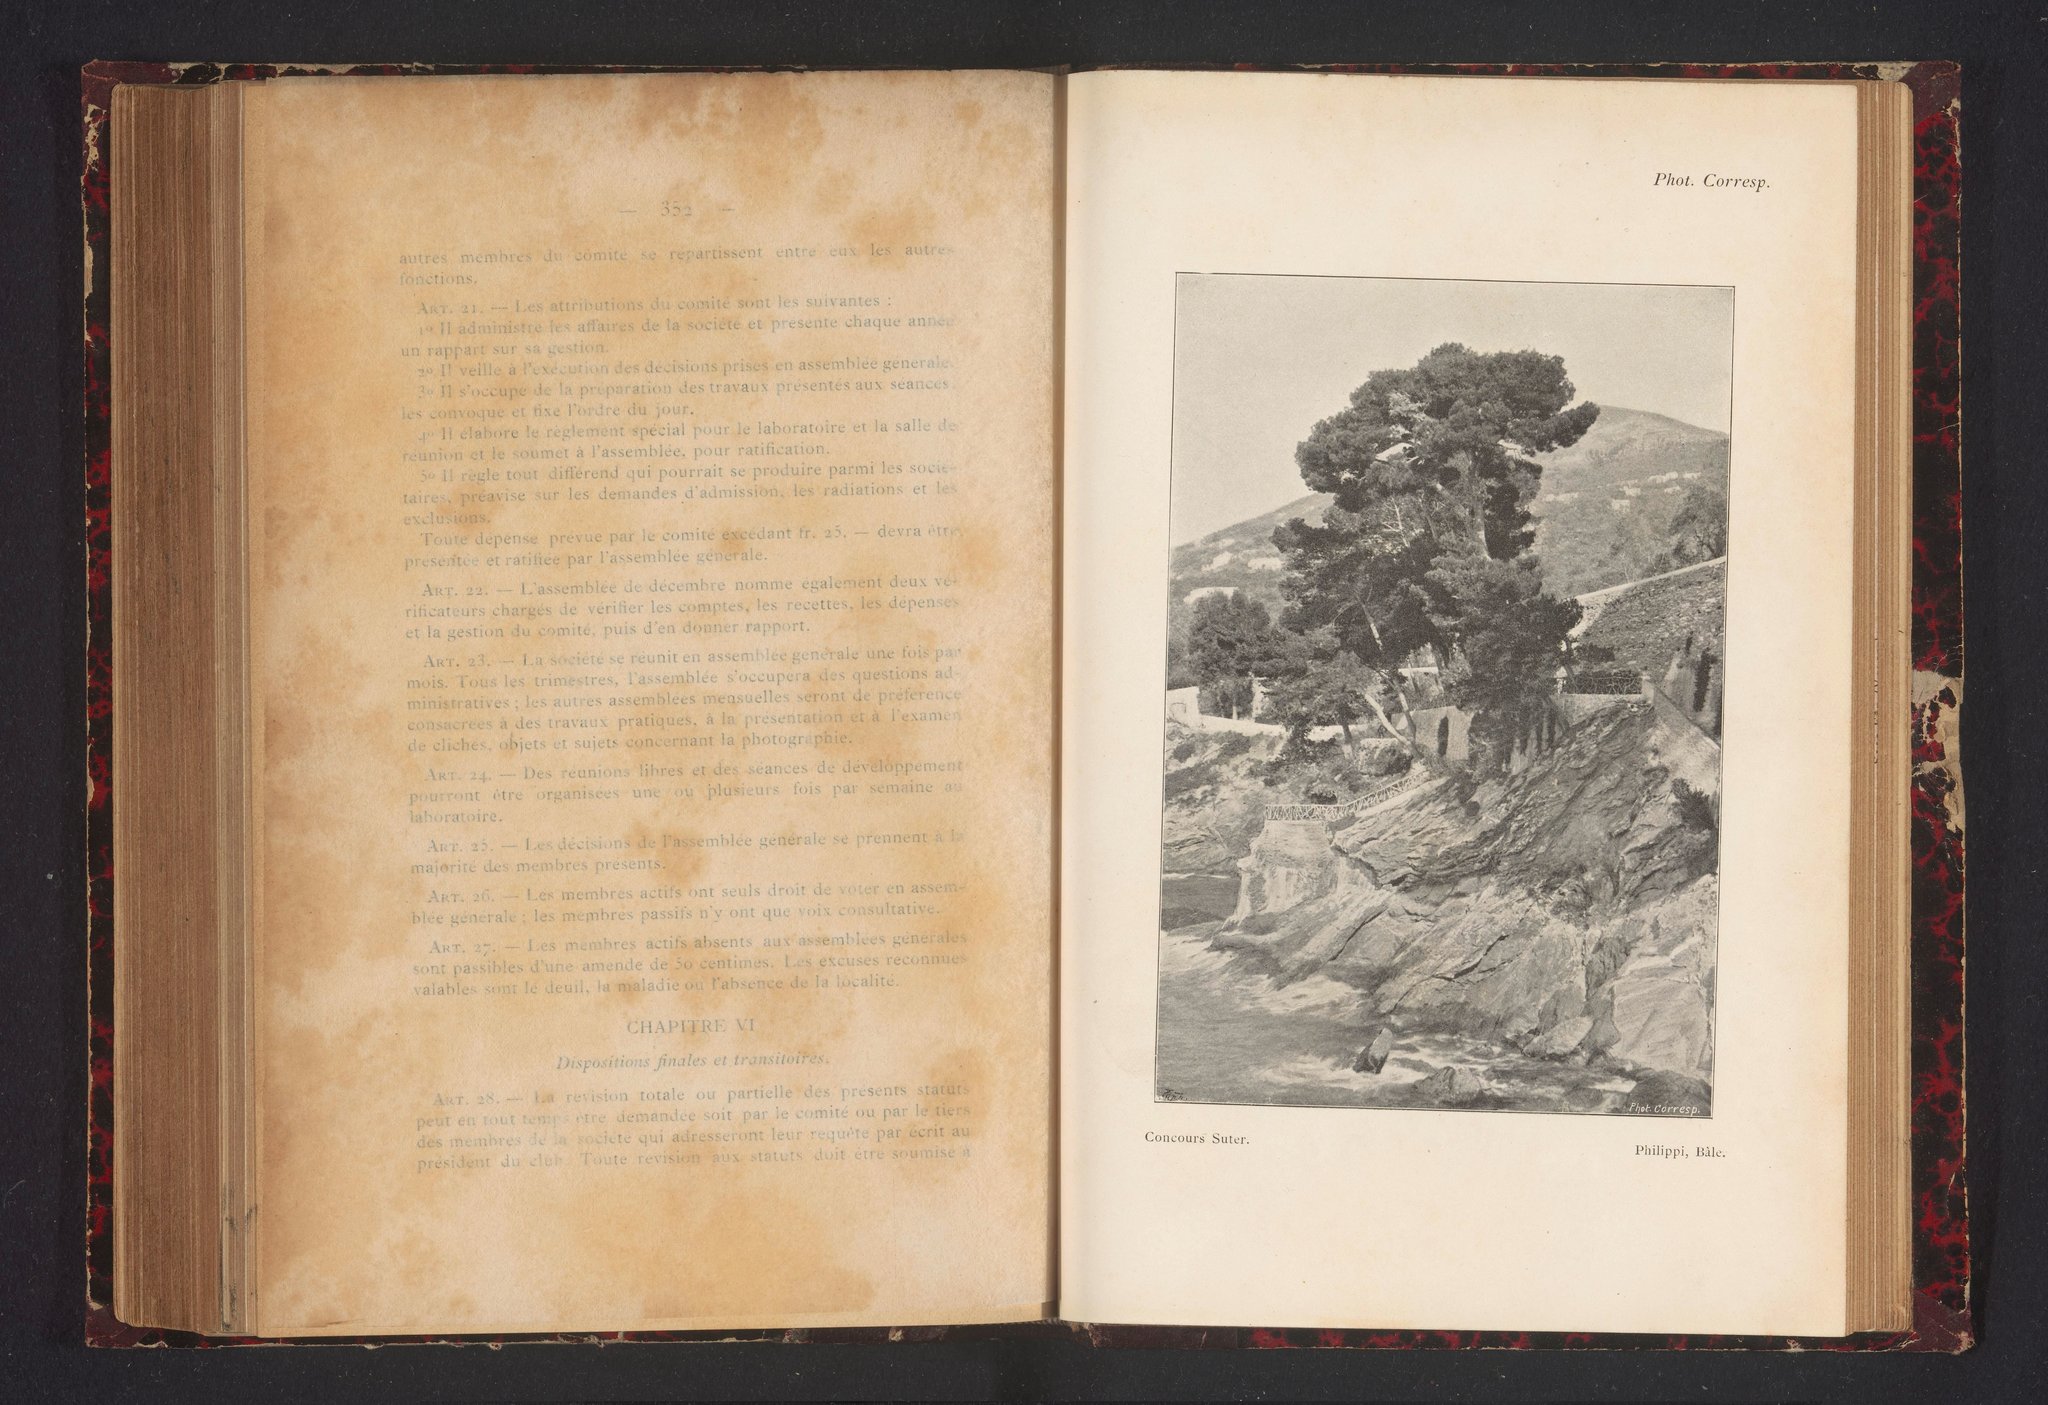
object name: page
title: Berglandschap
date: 1894-1899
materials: paper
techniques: autotype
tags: trees, landscapes, mountains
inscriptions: monogram: ‘AG ph.’, inscription: ‘Phot. Corresp.’, inscription: ‘Phot. Corresp.’, inscription: ‘Concours Suter’